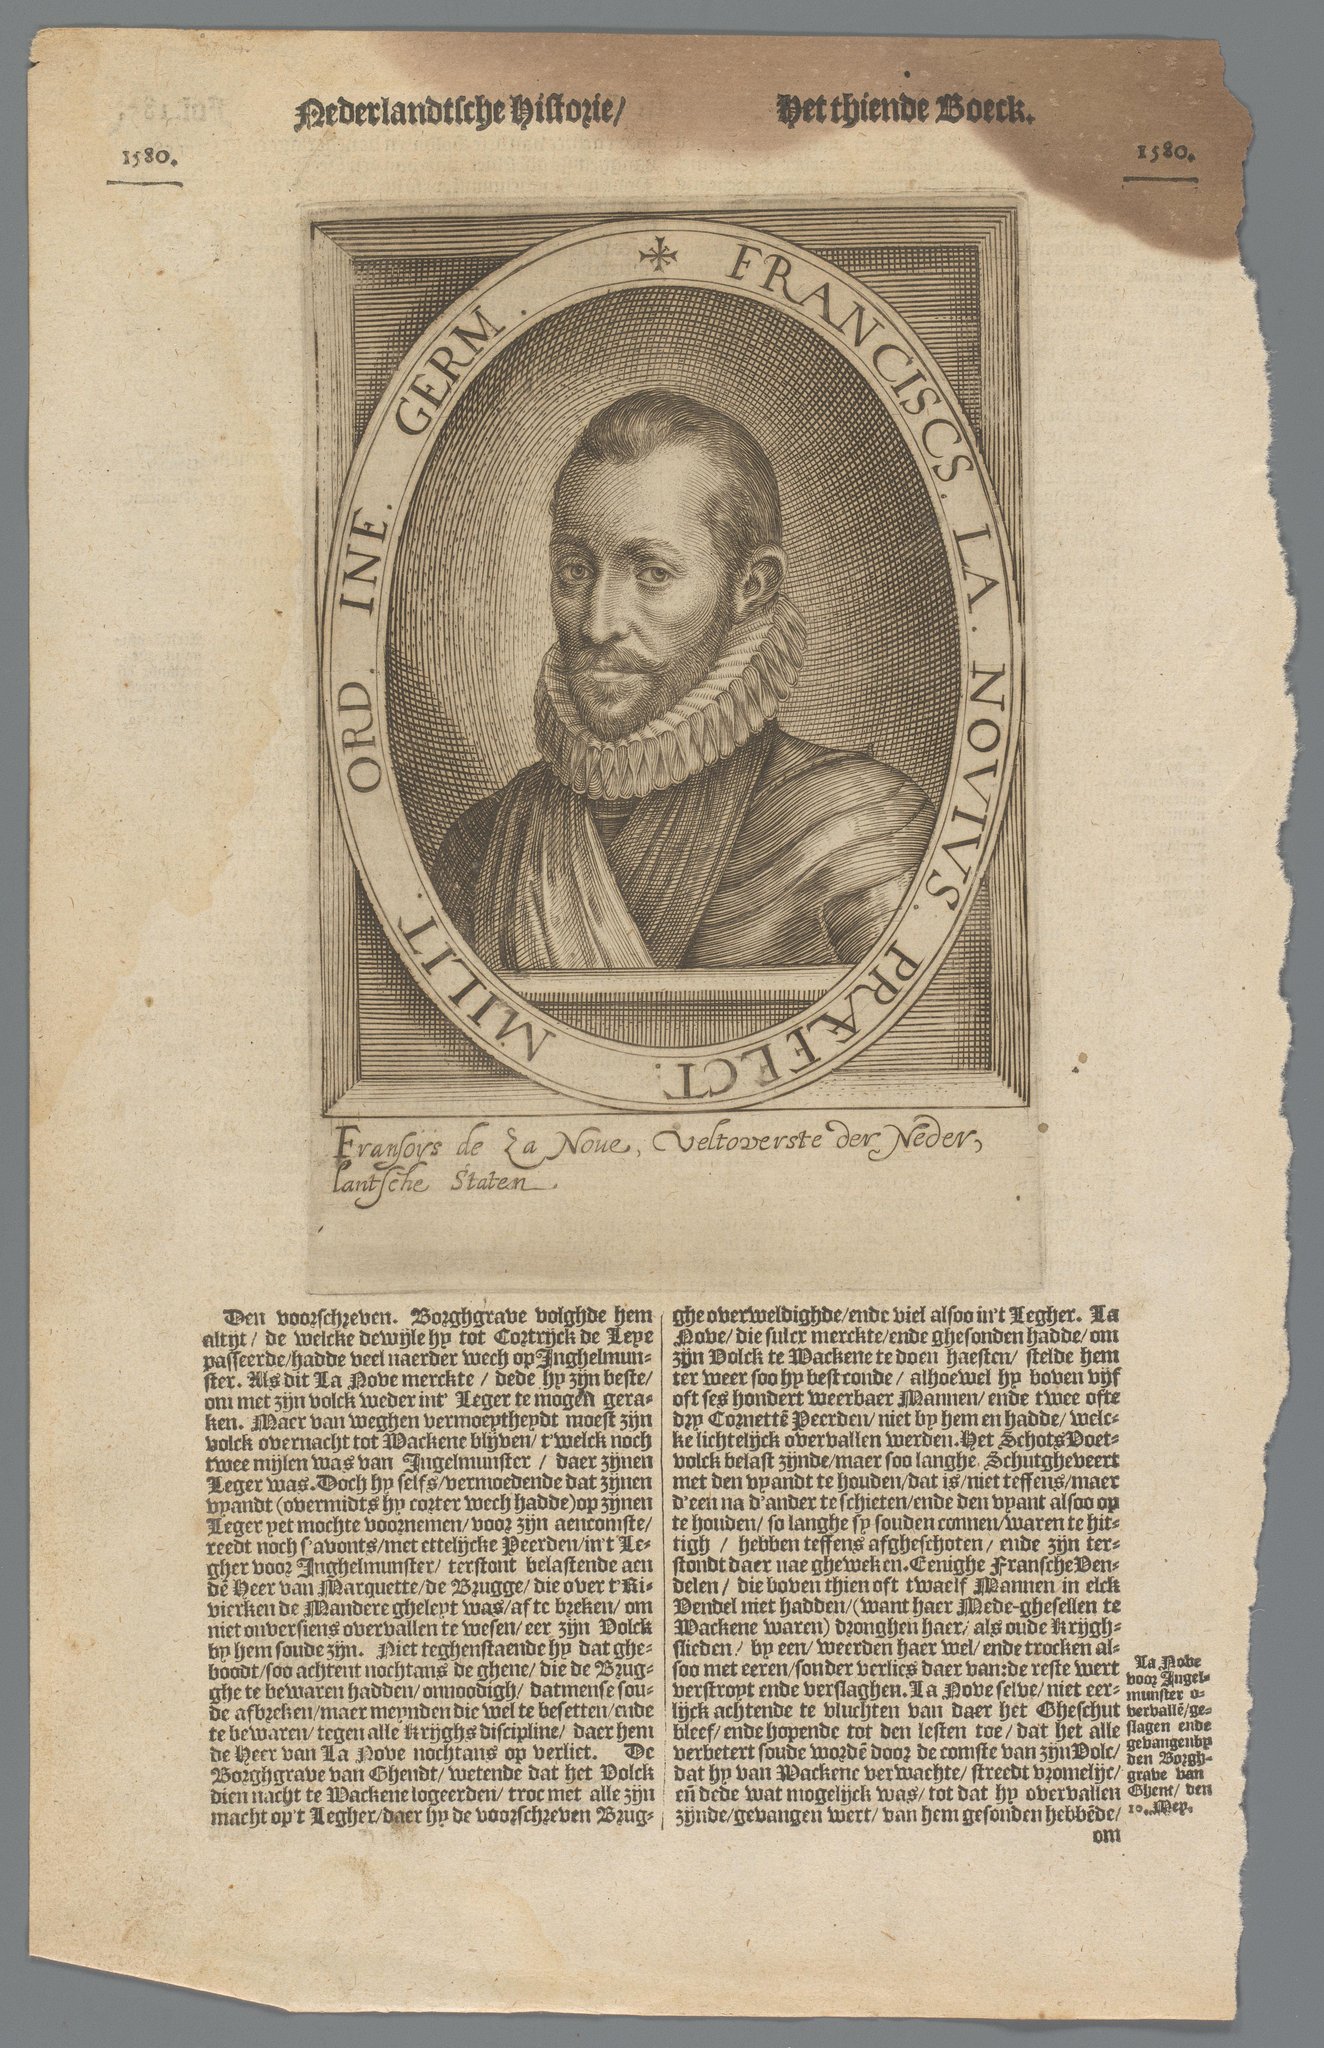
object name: text sheet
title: Portret van François de la Noue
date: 1614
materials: paper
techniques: engraving, letterpress printing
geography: the hague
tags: commander-in-chief, general, marshal, historical persons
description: Prent uit: Meteren, Emanuel van. Historie der Nederlandscher ende haerder na-buren oorlogen ende geschiedenissen (...). Den Haag: Hillebrant Iacobsz. van Wouw, 1614.